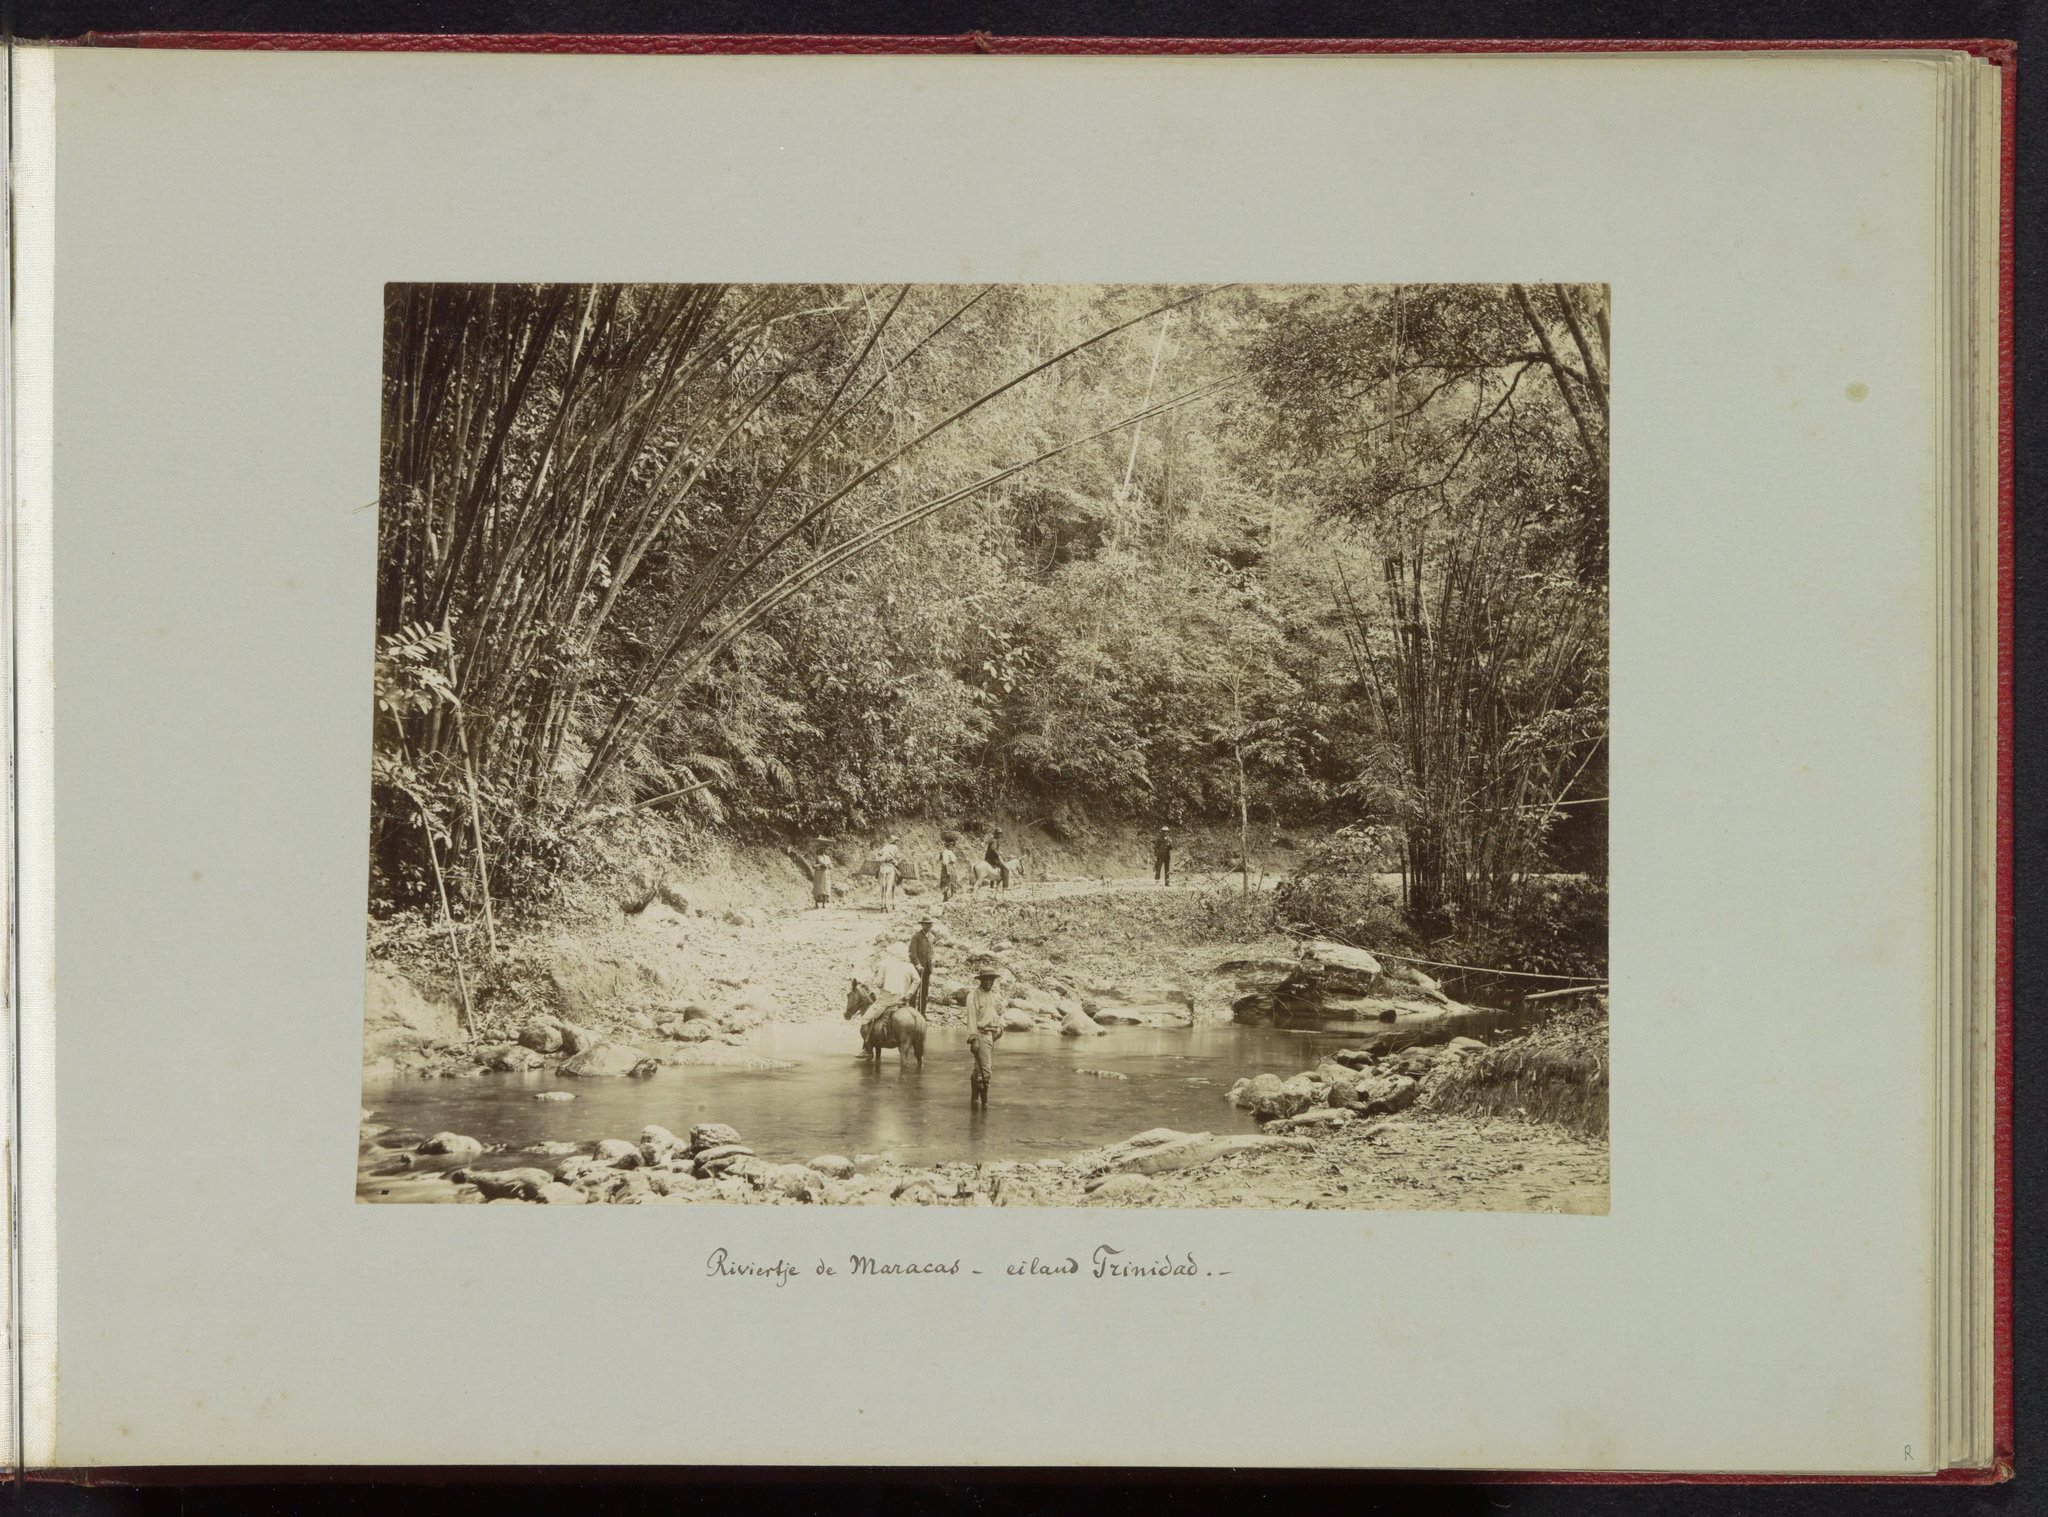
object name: photograph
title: Mensen langs de rivier de Maracas op het eiland Trinidad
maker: Anonymous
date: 1880-1900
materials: photographic support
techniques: albumen print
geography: trinidad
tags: spring, source of river or stream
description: Onderdeel van Fotoalbum met opnames van bezienswaardigheden in Europa, Trinidad, Haïti, Martinique en Suriname.